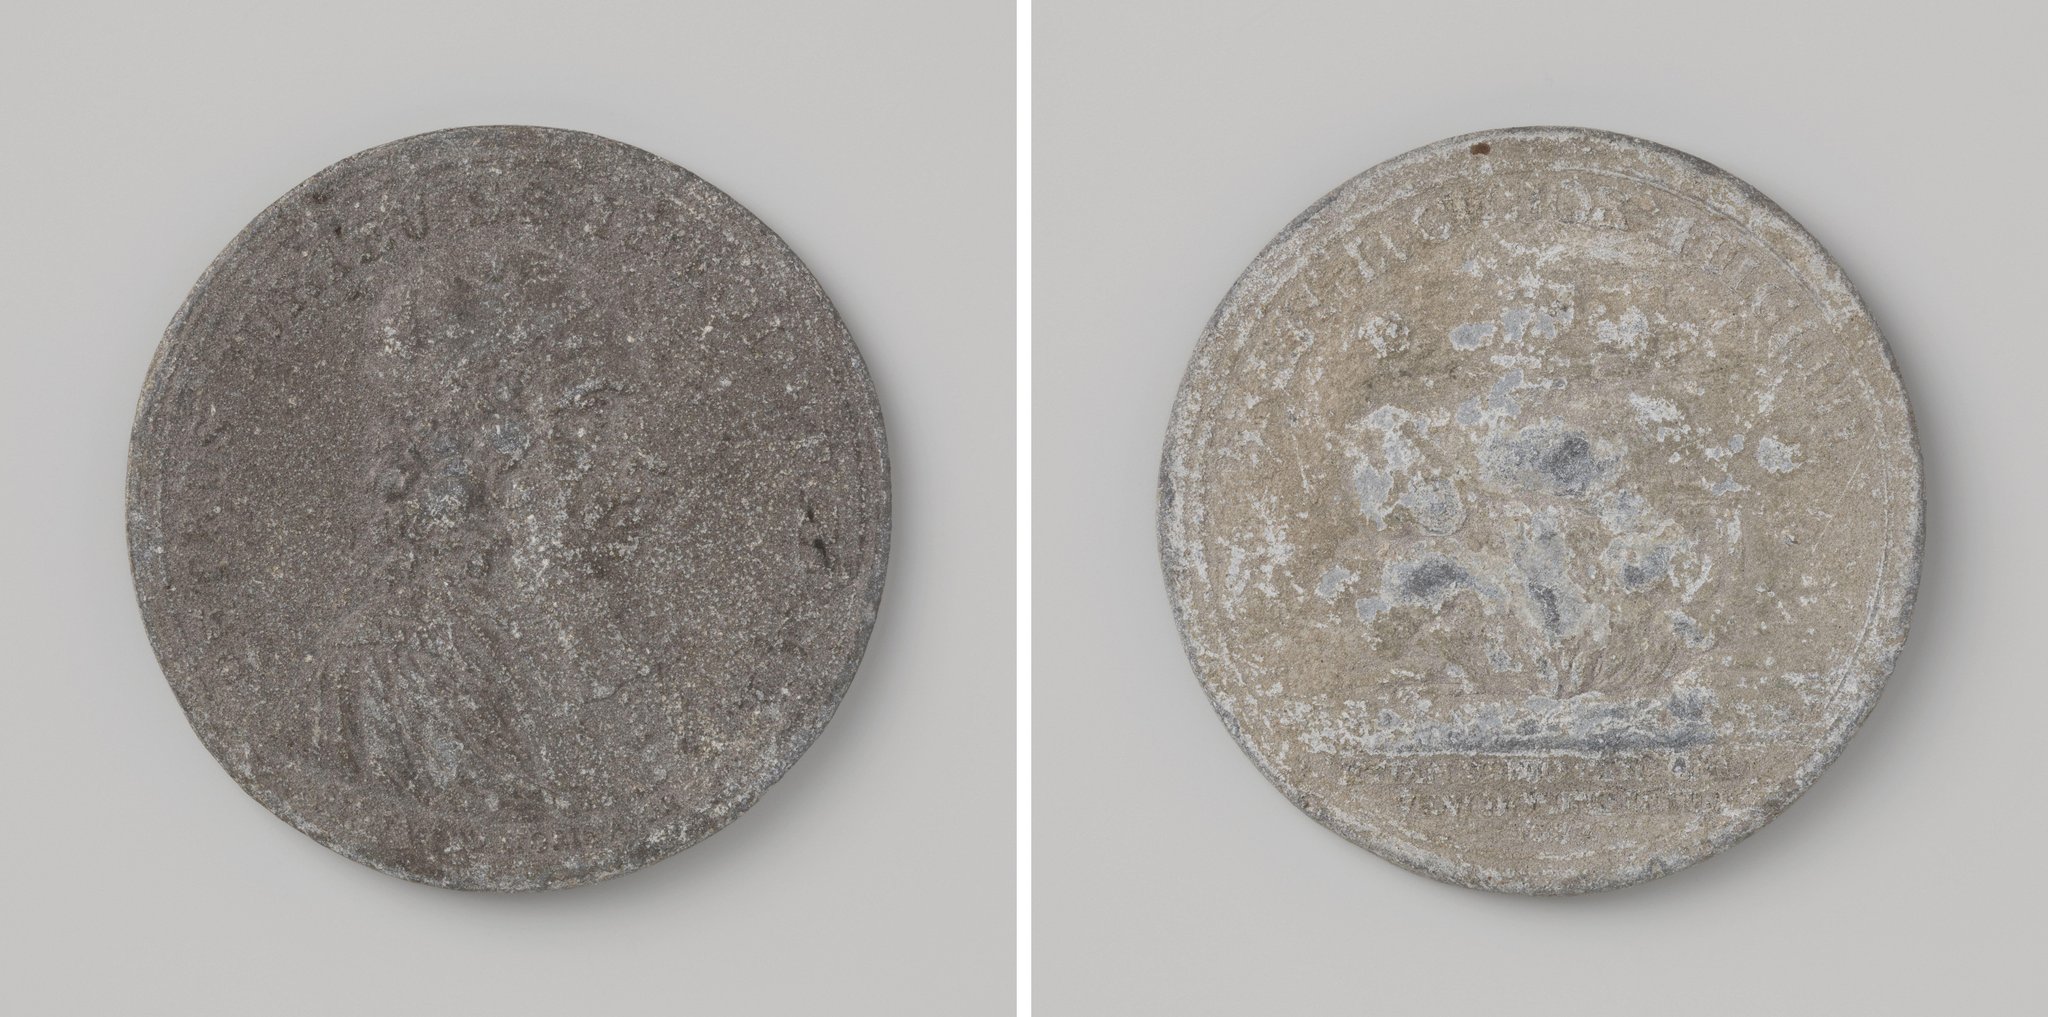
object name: history medal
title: Petrus Jurieu theoloog en voorspeller 1687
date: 1687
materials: tin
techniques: casting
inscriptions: inscription: ‘ETIAM VENIO CITO AMEN / VENI DOMINE JESV. / 1687.’, circumscription: ‘PETRUS IURIEU S.S. THEOL: P.P.’, circumscription: ‘BREVI LVCIDIOR FVLGEBIT’, inscription: ‘SPE FATI MELIORIS ALOR’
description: Tinnen penning, vrijwel onleesbaar, op de voorzijde het borstbeeld van Jurieu naar rechts met omschrift en afsnedetekst, op de keerzijde een kerk en de zon, waarop het zicht verduisterd wordt door rook uit de onderwereld, met omschrift en afsnedetekst.